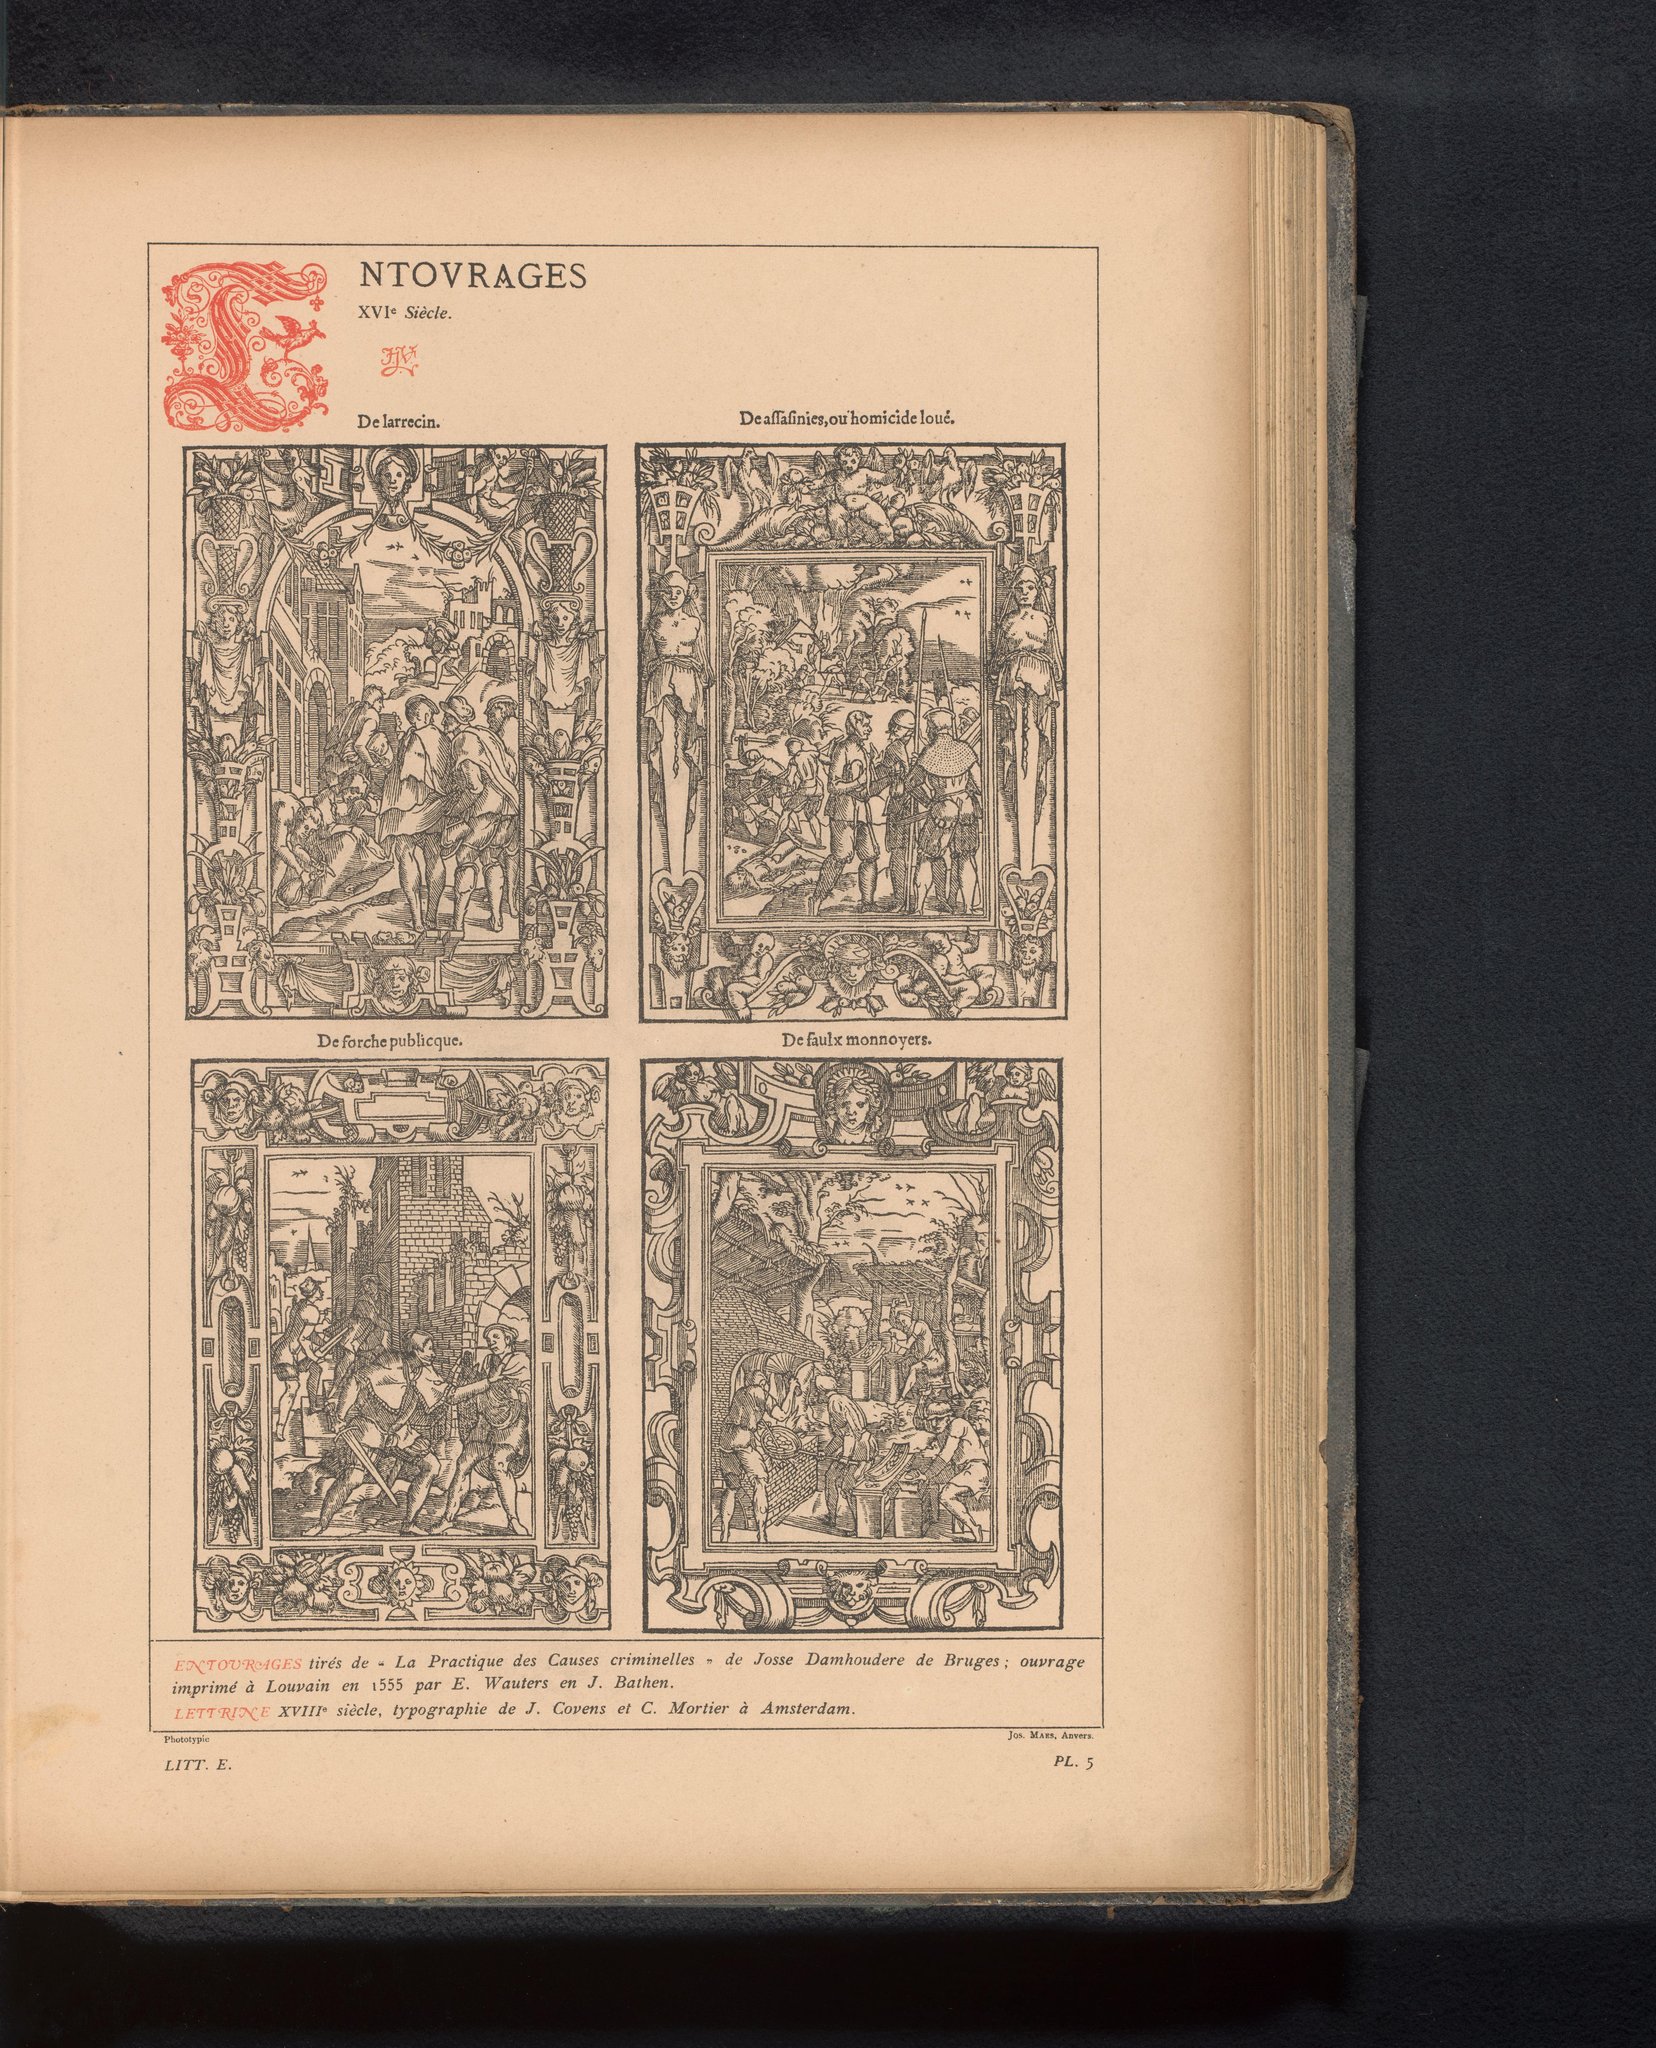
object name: photomechanical print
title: Reproductie van vier prenten uit La Practique des Causes criminelles van Josse de Damhoudere, afgebeeld verschillende criminele activiteiten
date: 1875-1880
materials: paper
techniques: photolithography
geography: amsterdam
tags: crime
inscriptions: monogram: ‘JJvY’, inscription: ‘ENTOURAGES tirés de (...)’, inscription: ‘LITT. E. - PL. 5’